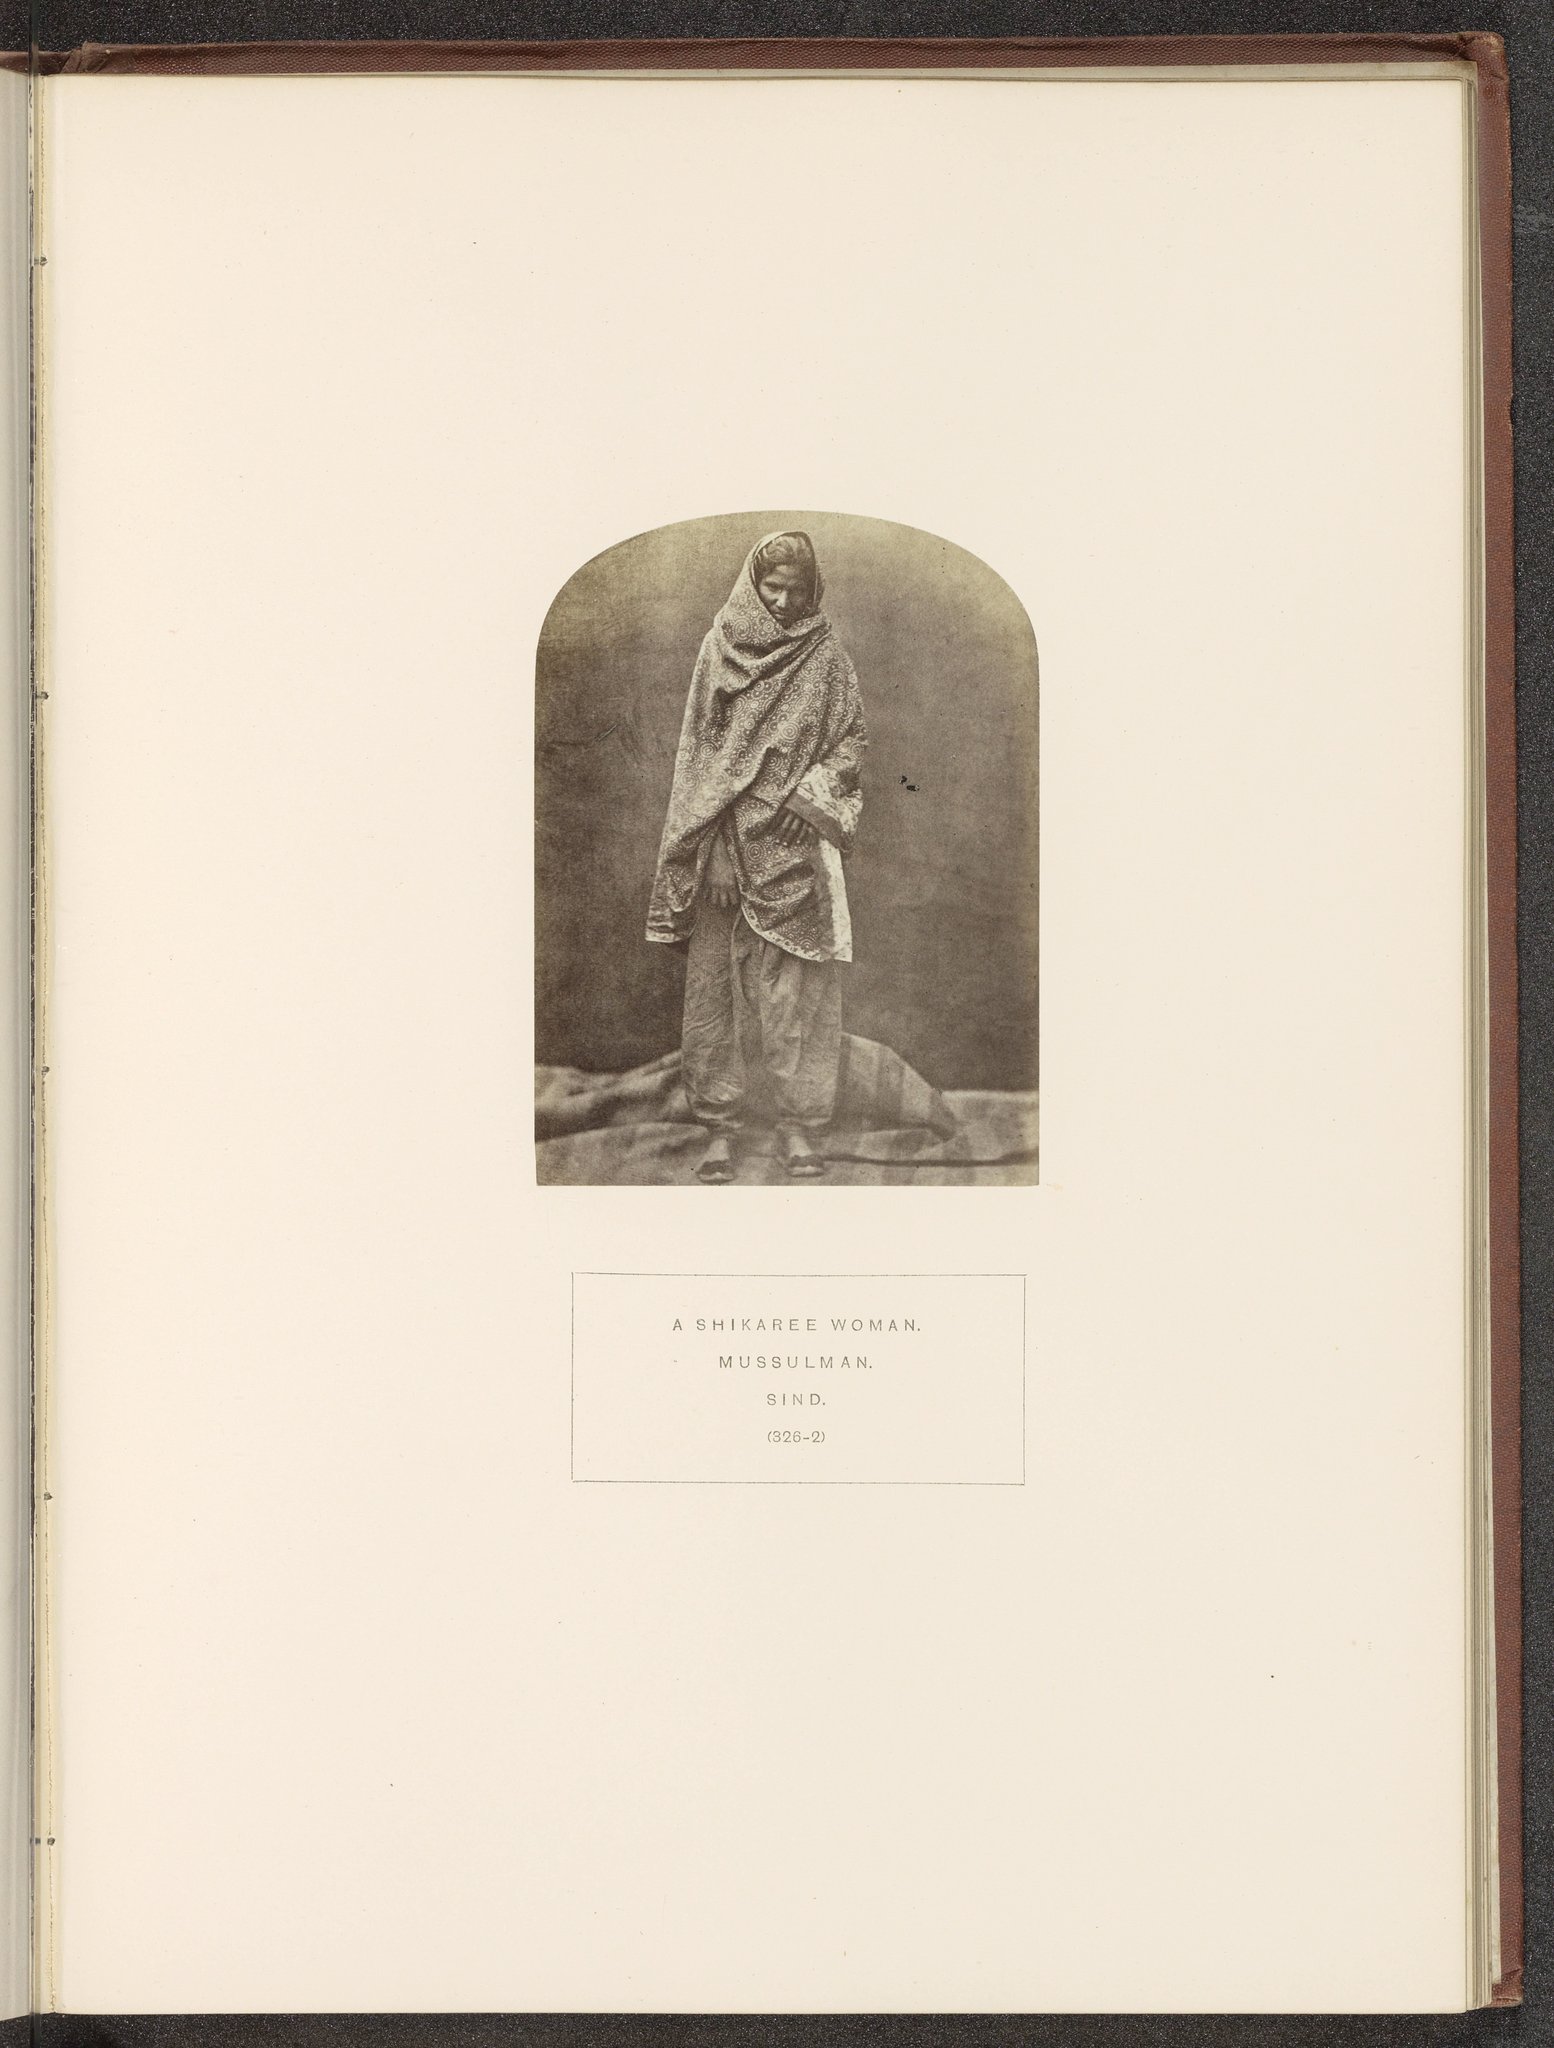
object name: photograph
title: Portrait of an unknown huntress with a headscarf from Sindh, Pakistan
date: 1862-1872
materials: photographic support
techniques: albumen print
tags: head-gear (with name), human races; peoples; nationalities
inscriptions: number: ‘(326-2)’, inscription: ‘A SHIKAREE WOMAN./ MUSSULMAN./ SIND.’